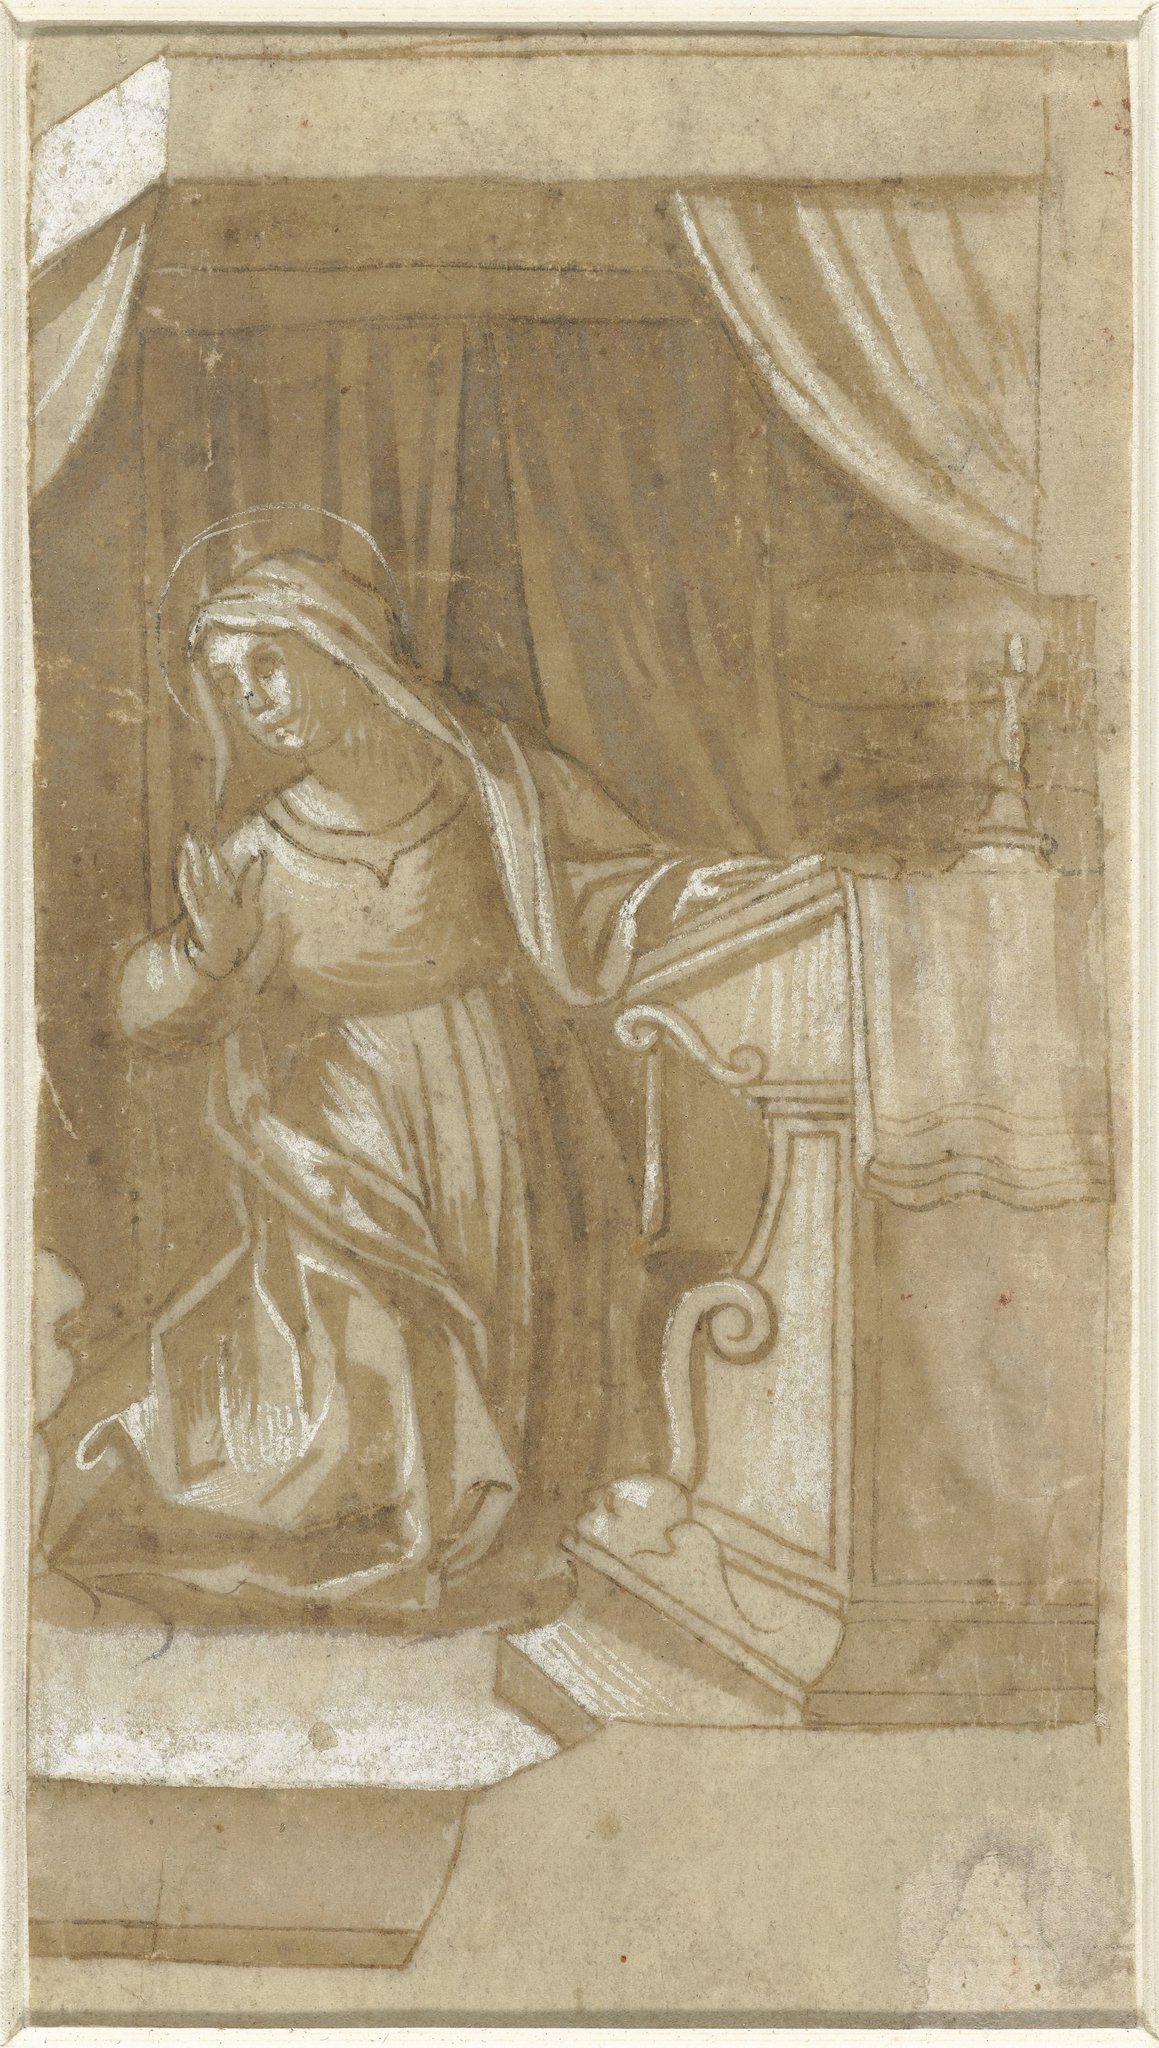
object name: drawing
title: Knielende Maria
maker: Anonymous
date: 1500-1510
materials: ink, paper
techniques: brush, pen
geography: northern italy